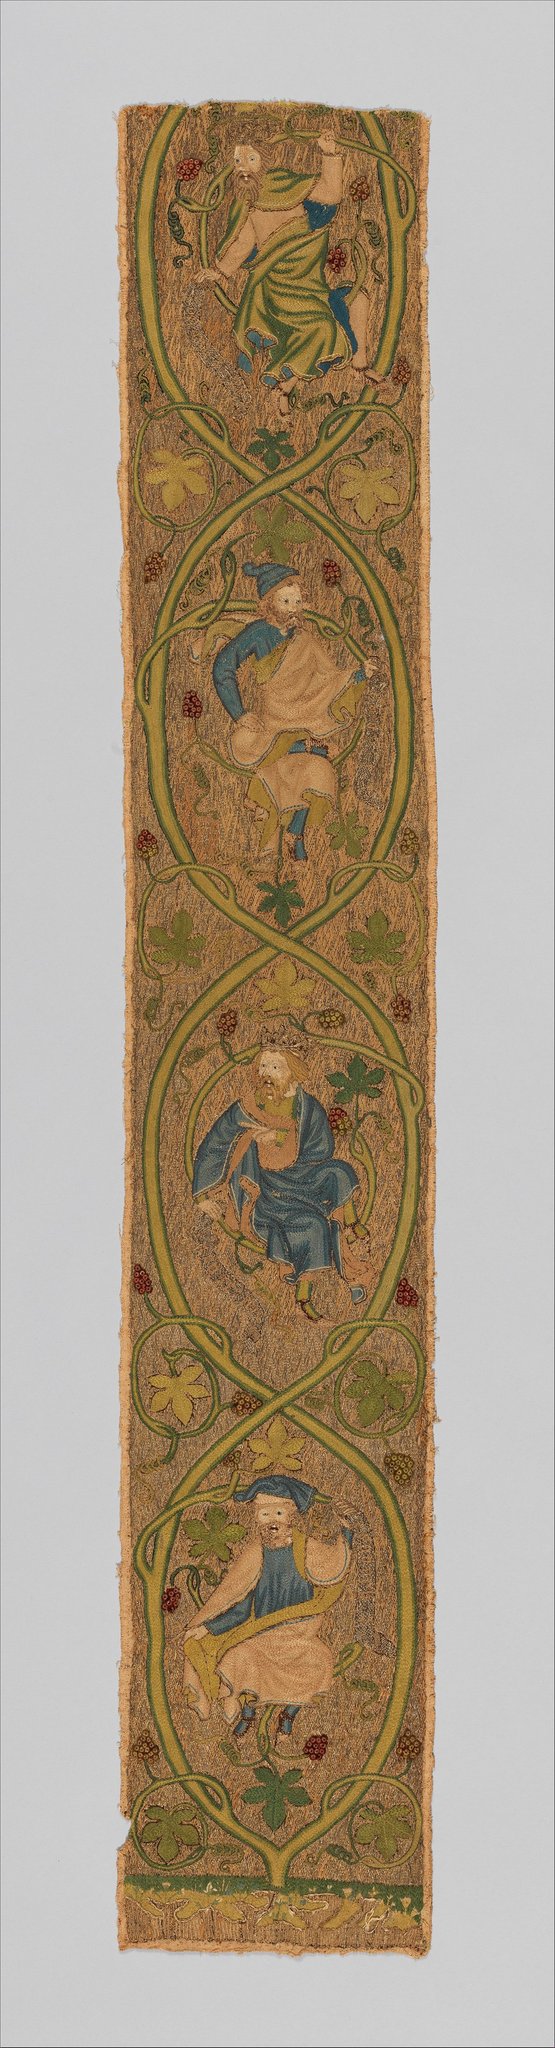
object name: orphrey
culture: british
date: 1351-1375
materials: linen, metal, silk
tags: grapes,men